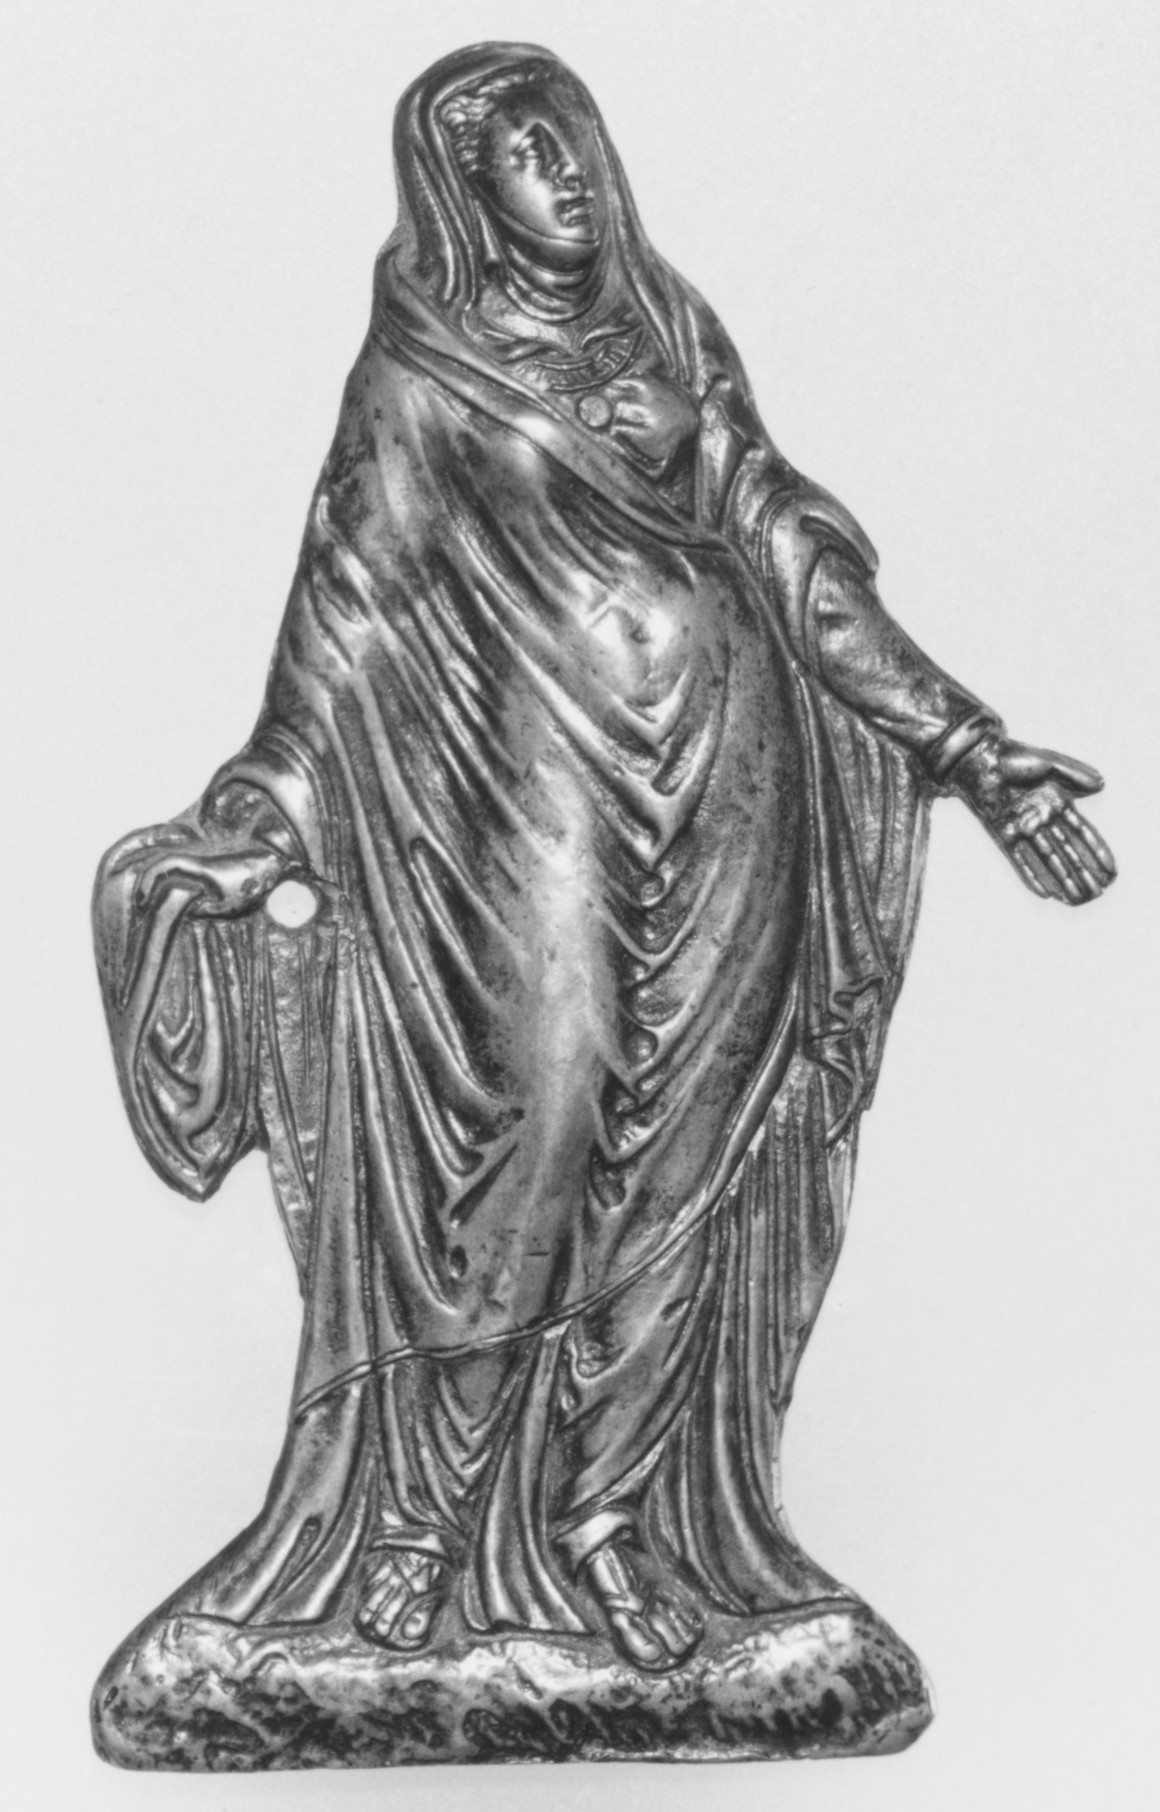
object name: relief figure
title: Mourning Virgin from a Crucifixion Group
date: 1501-1600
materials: bronze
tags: virgin mary,crucifixion